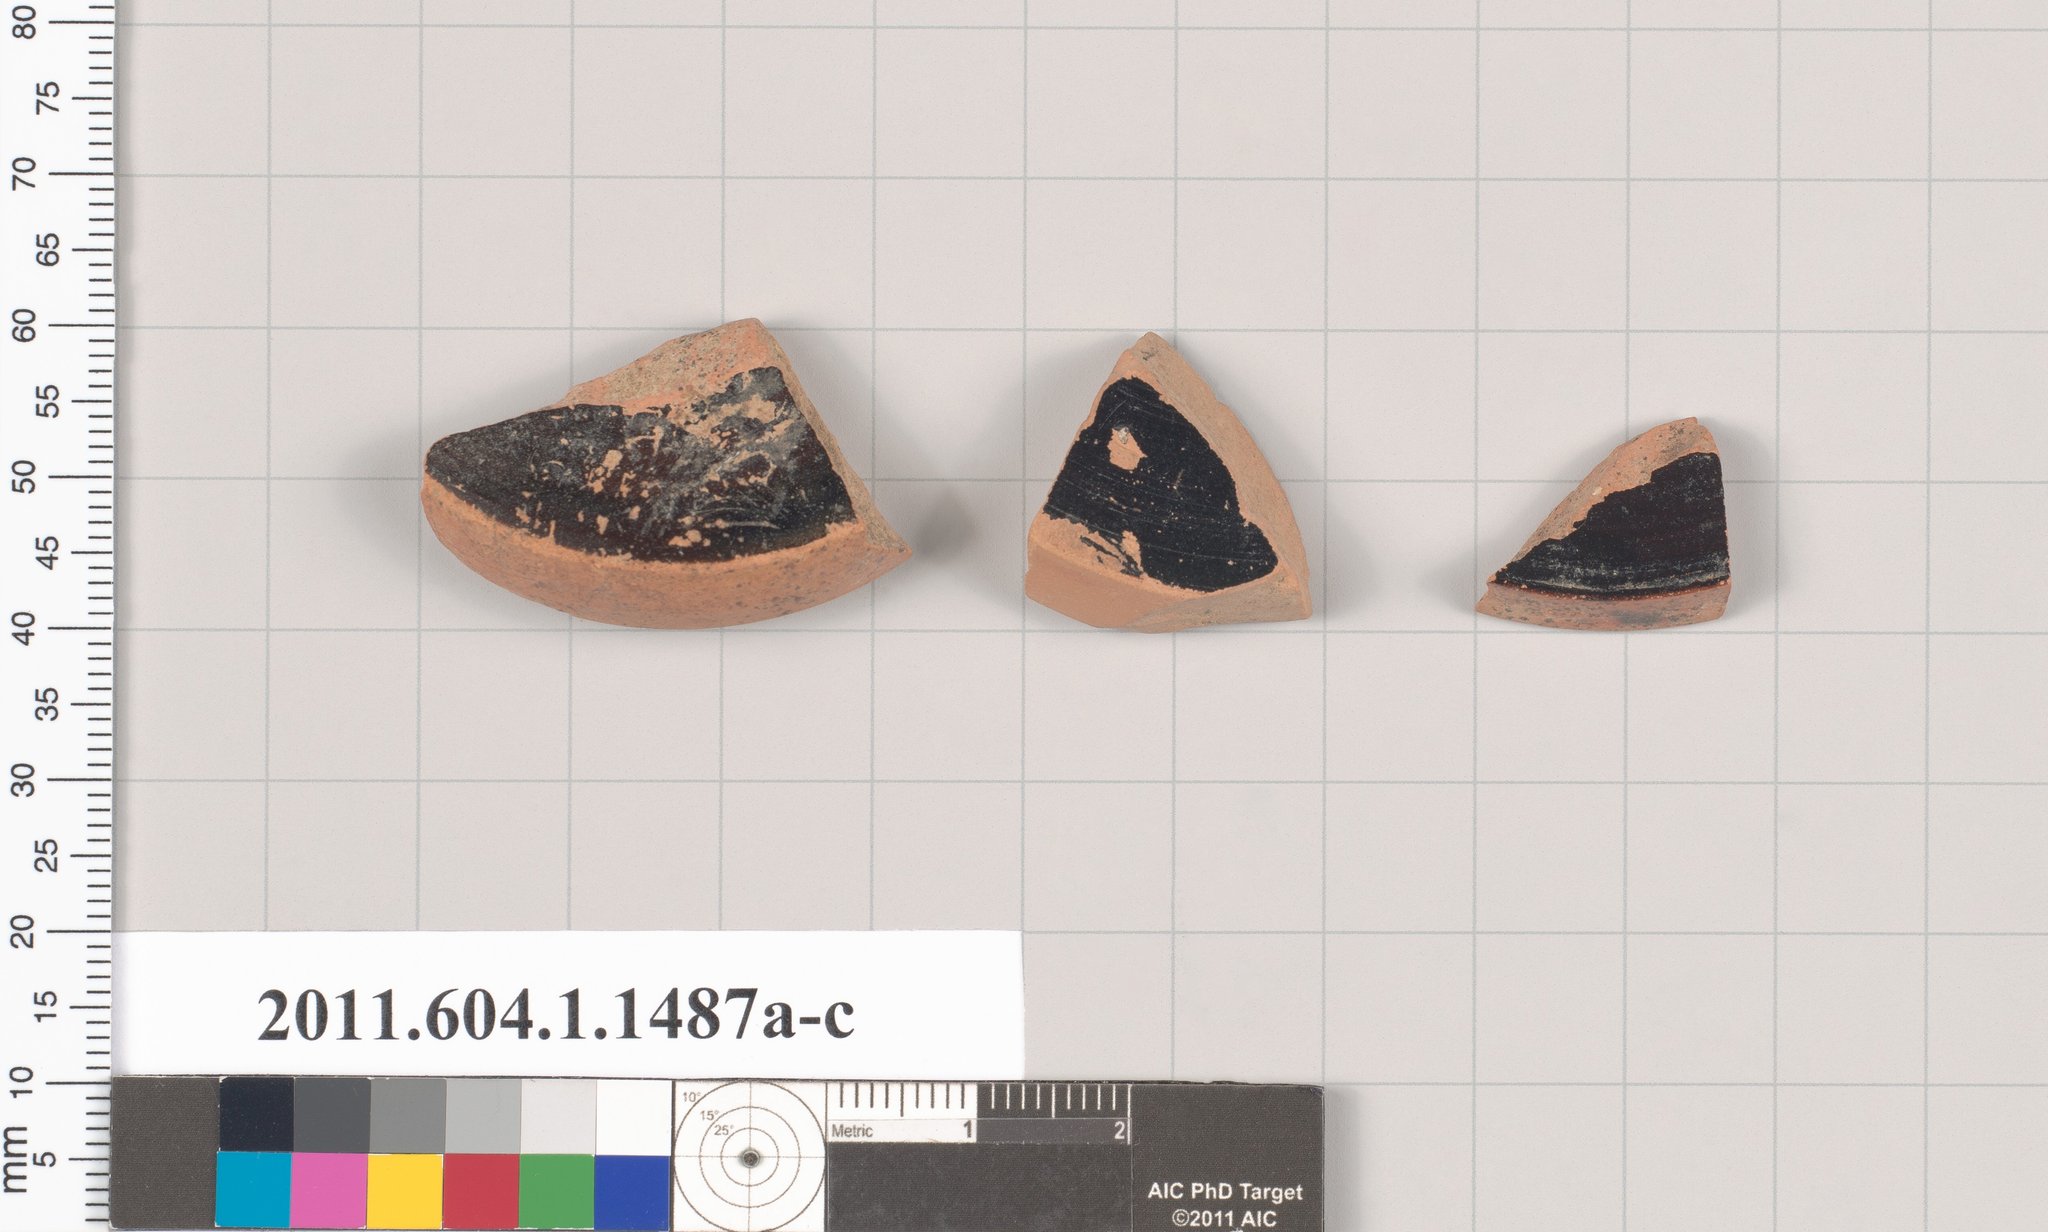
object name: kylix fragment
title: Terracotta fragments of kylikes (drinking cups)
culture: greek, attic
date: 500-401 BCE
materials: terracotta